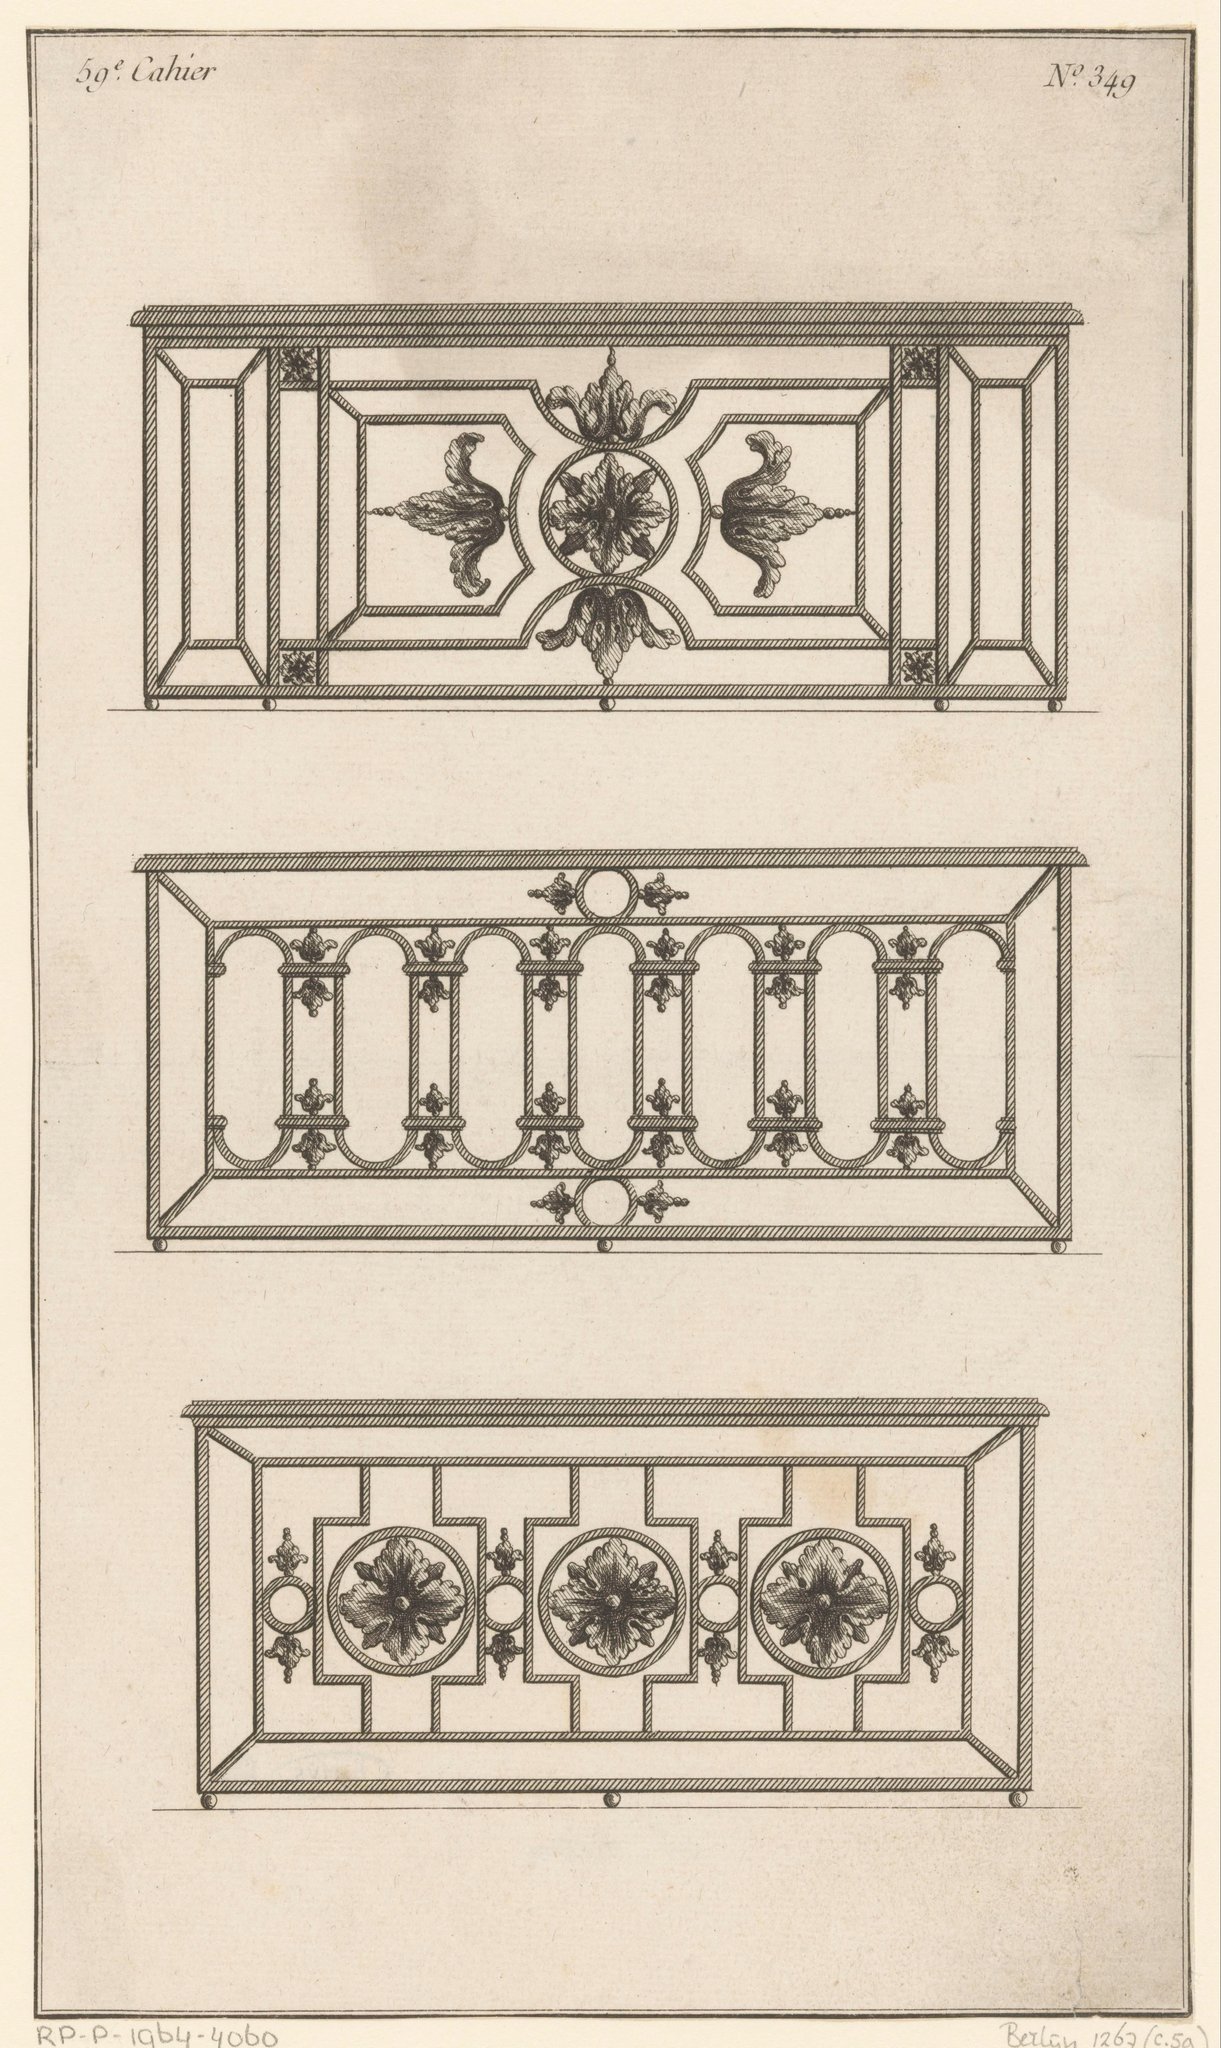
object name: print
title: 59e Cahier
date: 1772-1779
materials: paper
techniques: engraving, etching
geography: paris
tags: fence, wall, paling, flowers ~ ornament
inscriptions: collector's mark: Lugt 2760, collector's mark: Lugt 2228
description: Drie smeedijzeren hekken met bloemmotieven. Prentnummer 349.